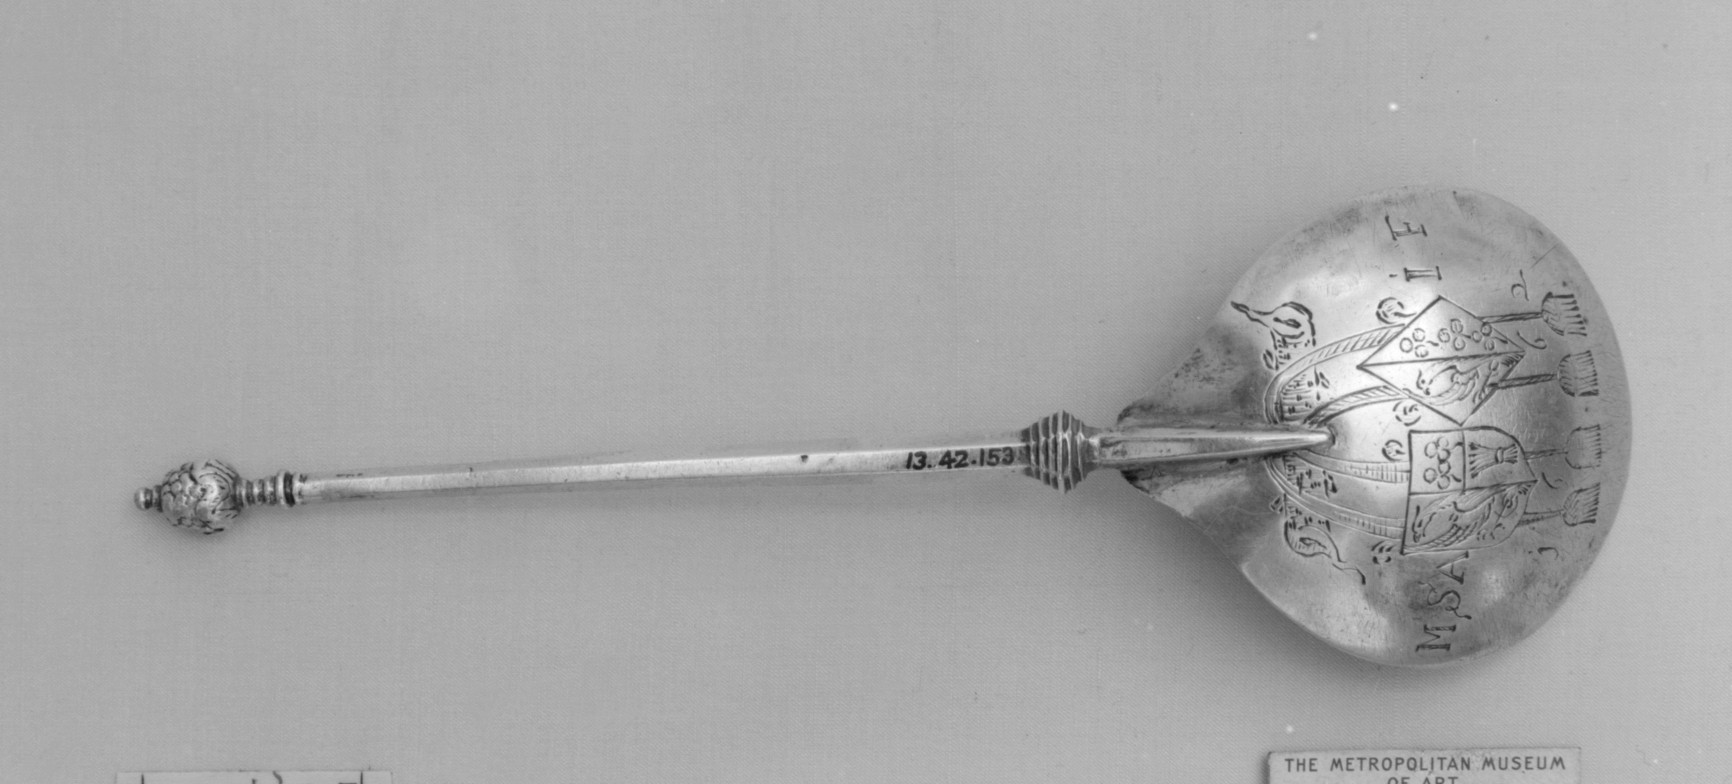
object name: spoon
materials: silver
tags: coat of arms